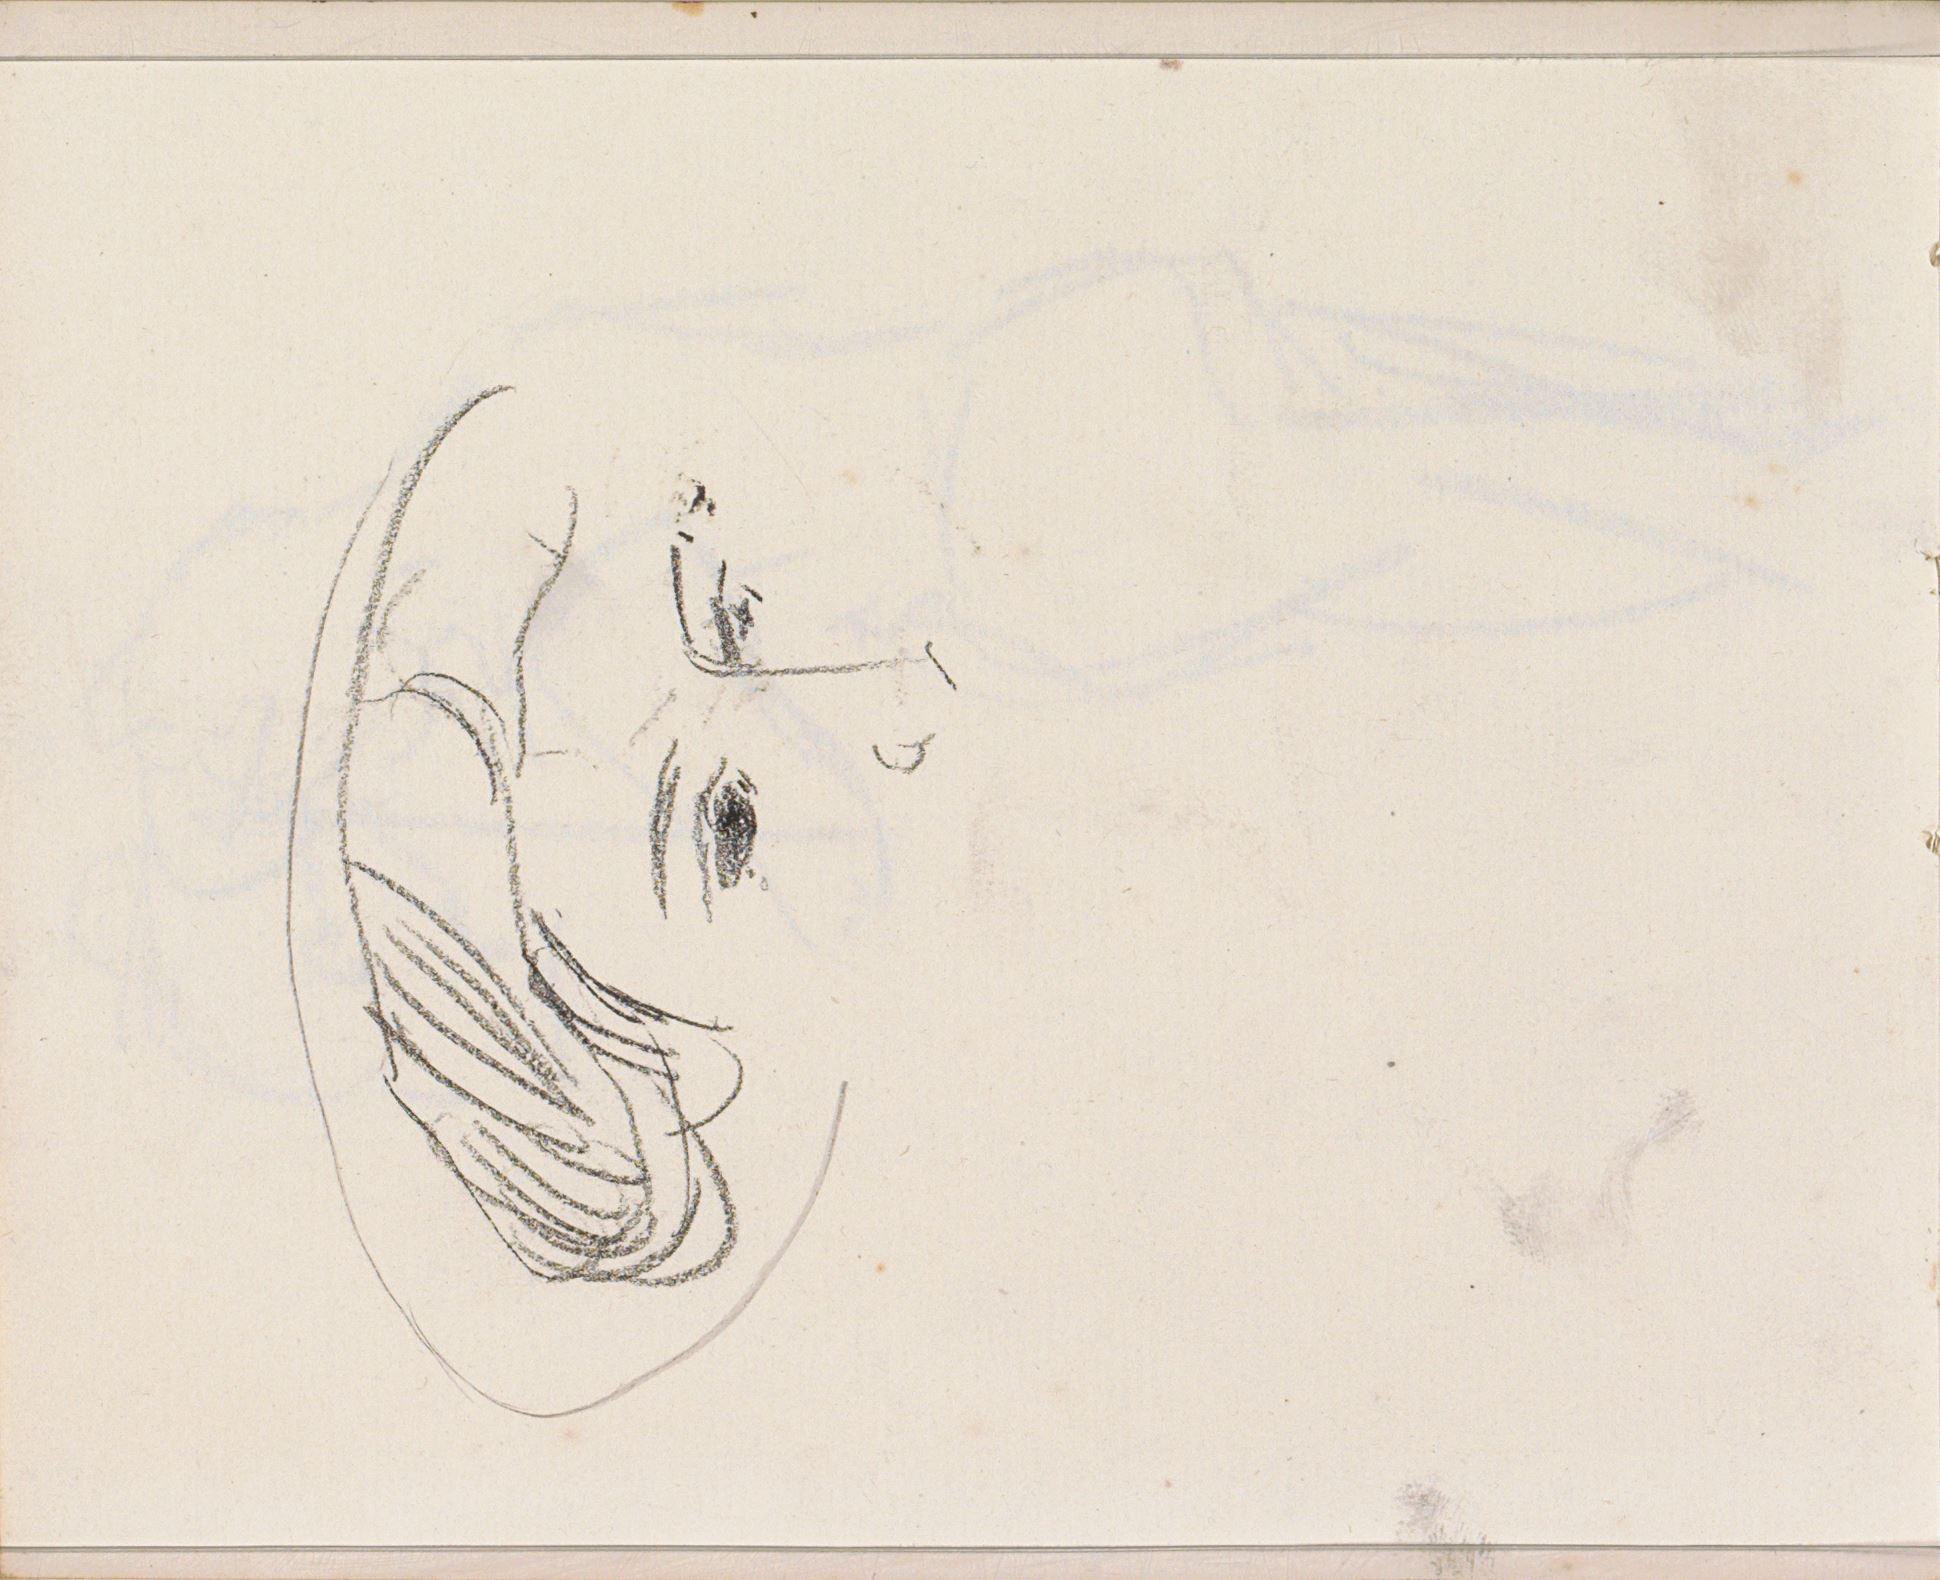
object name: sketchbook leaf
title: Vrouwenhoofd met hoed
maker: isaac israels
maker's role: draughtsman, painter, print maker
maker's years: 1865-1934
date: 1875-1934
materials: chalk, paper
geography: the hague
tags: head-gear: hat (+ women's clothes), head (human) - aa - female human figure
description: Pagina 29 uit schetsboek XLIII met 61 pagina's.